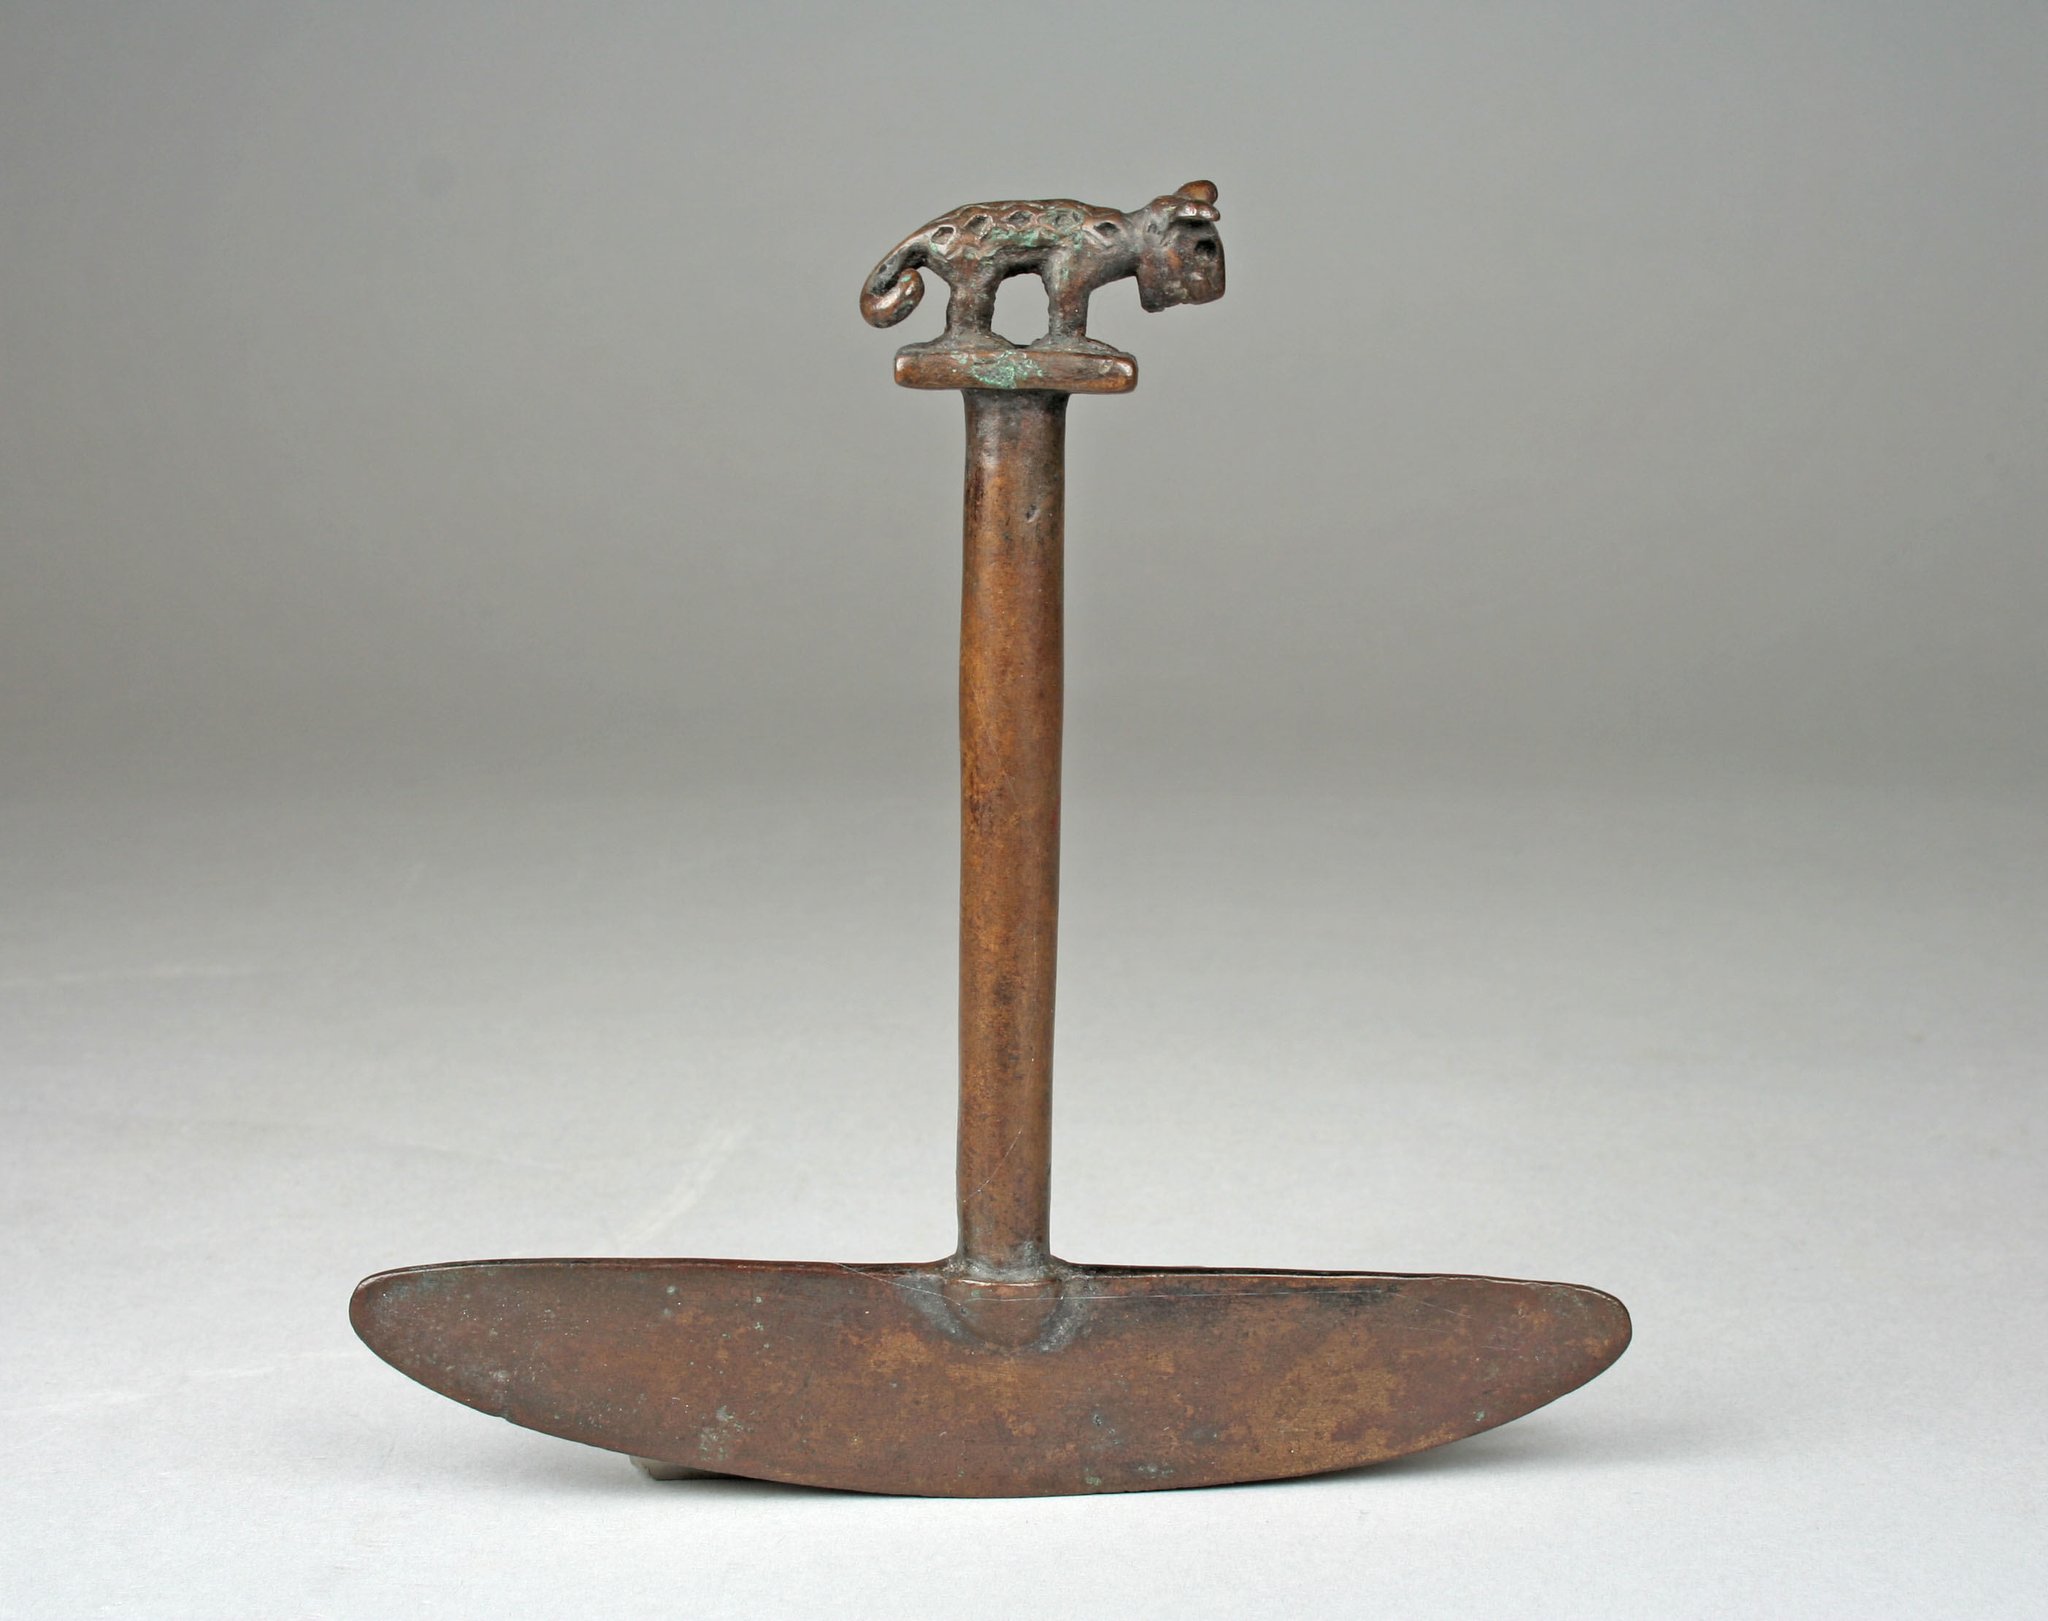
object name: knife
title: Ceremonial Knife (Tumi)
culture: inca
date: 1401-1500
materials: copper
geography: peru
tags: animals